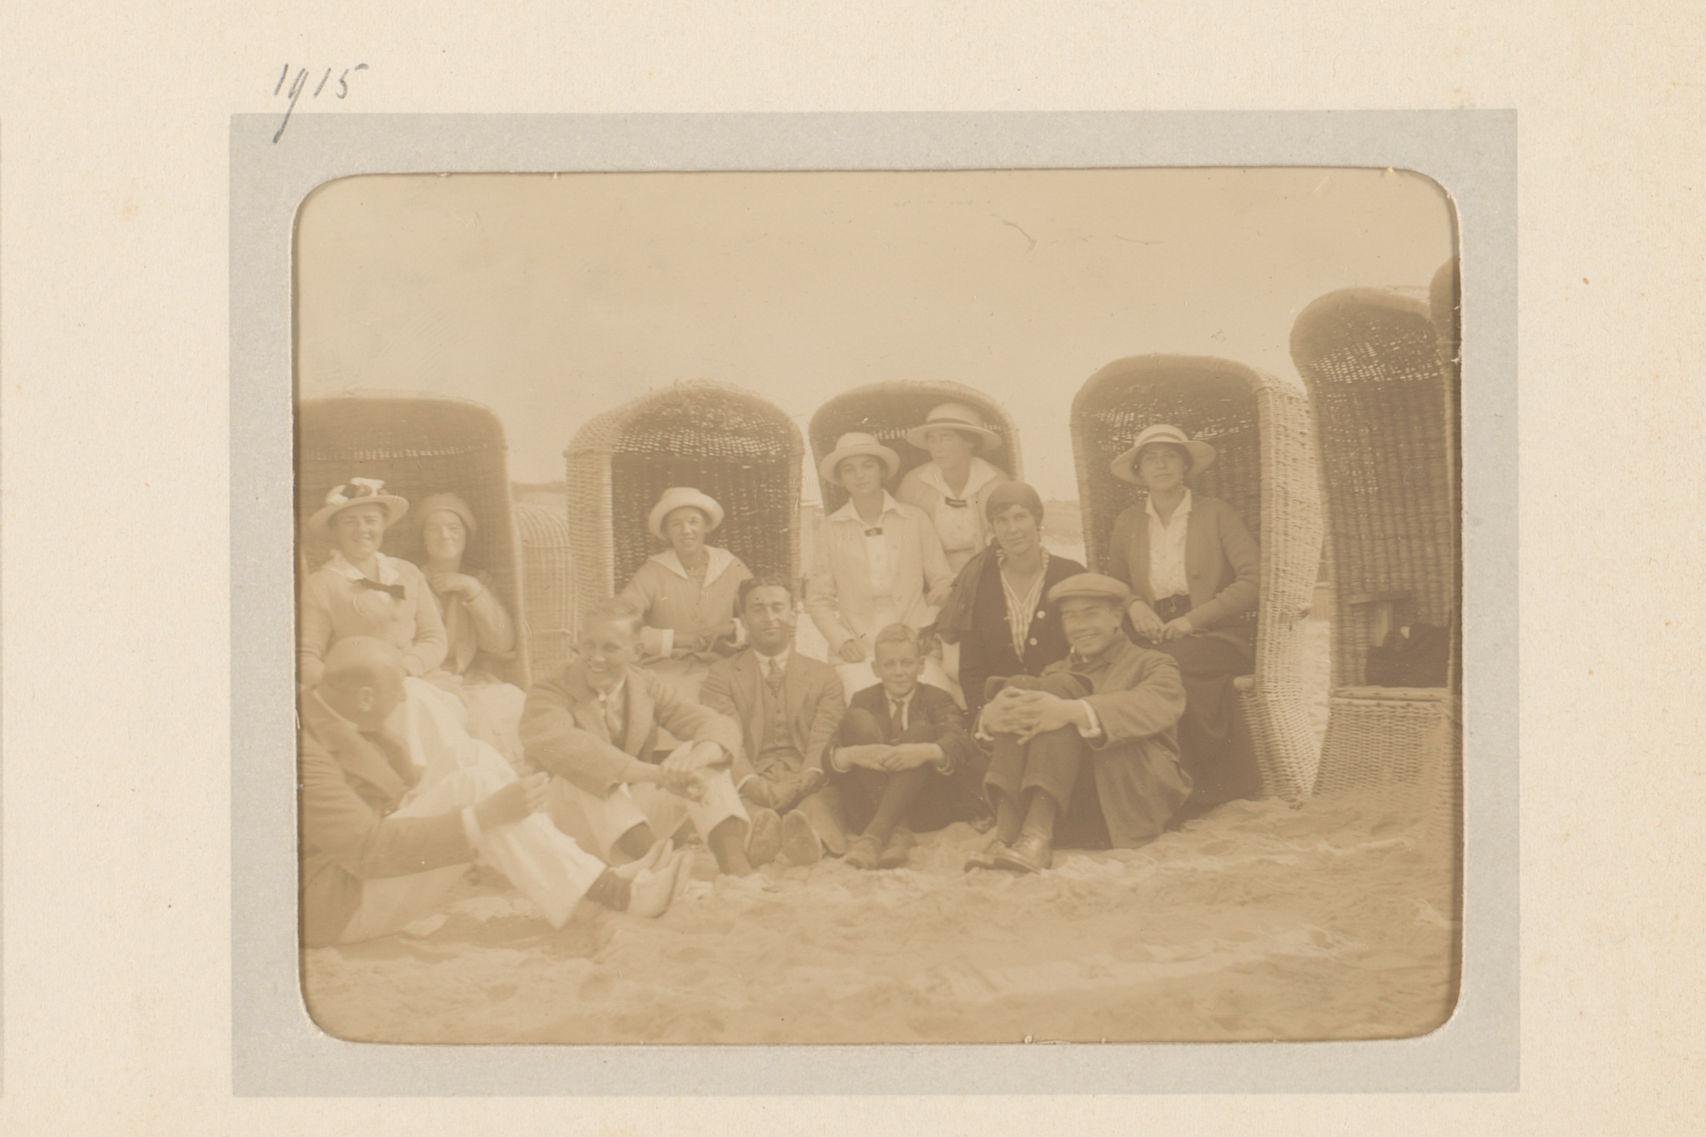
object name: photograph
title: Groepsportret van een gezelschap zittend in en rondom strandstoelen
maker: liesbeth overhoff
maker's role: fotograaf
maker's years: 1895-1969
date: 1915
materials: paper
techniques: gelatin silver print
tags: beach (as place of recreation), historical persons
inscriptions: inscription: ‘1915’